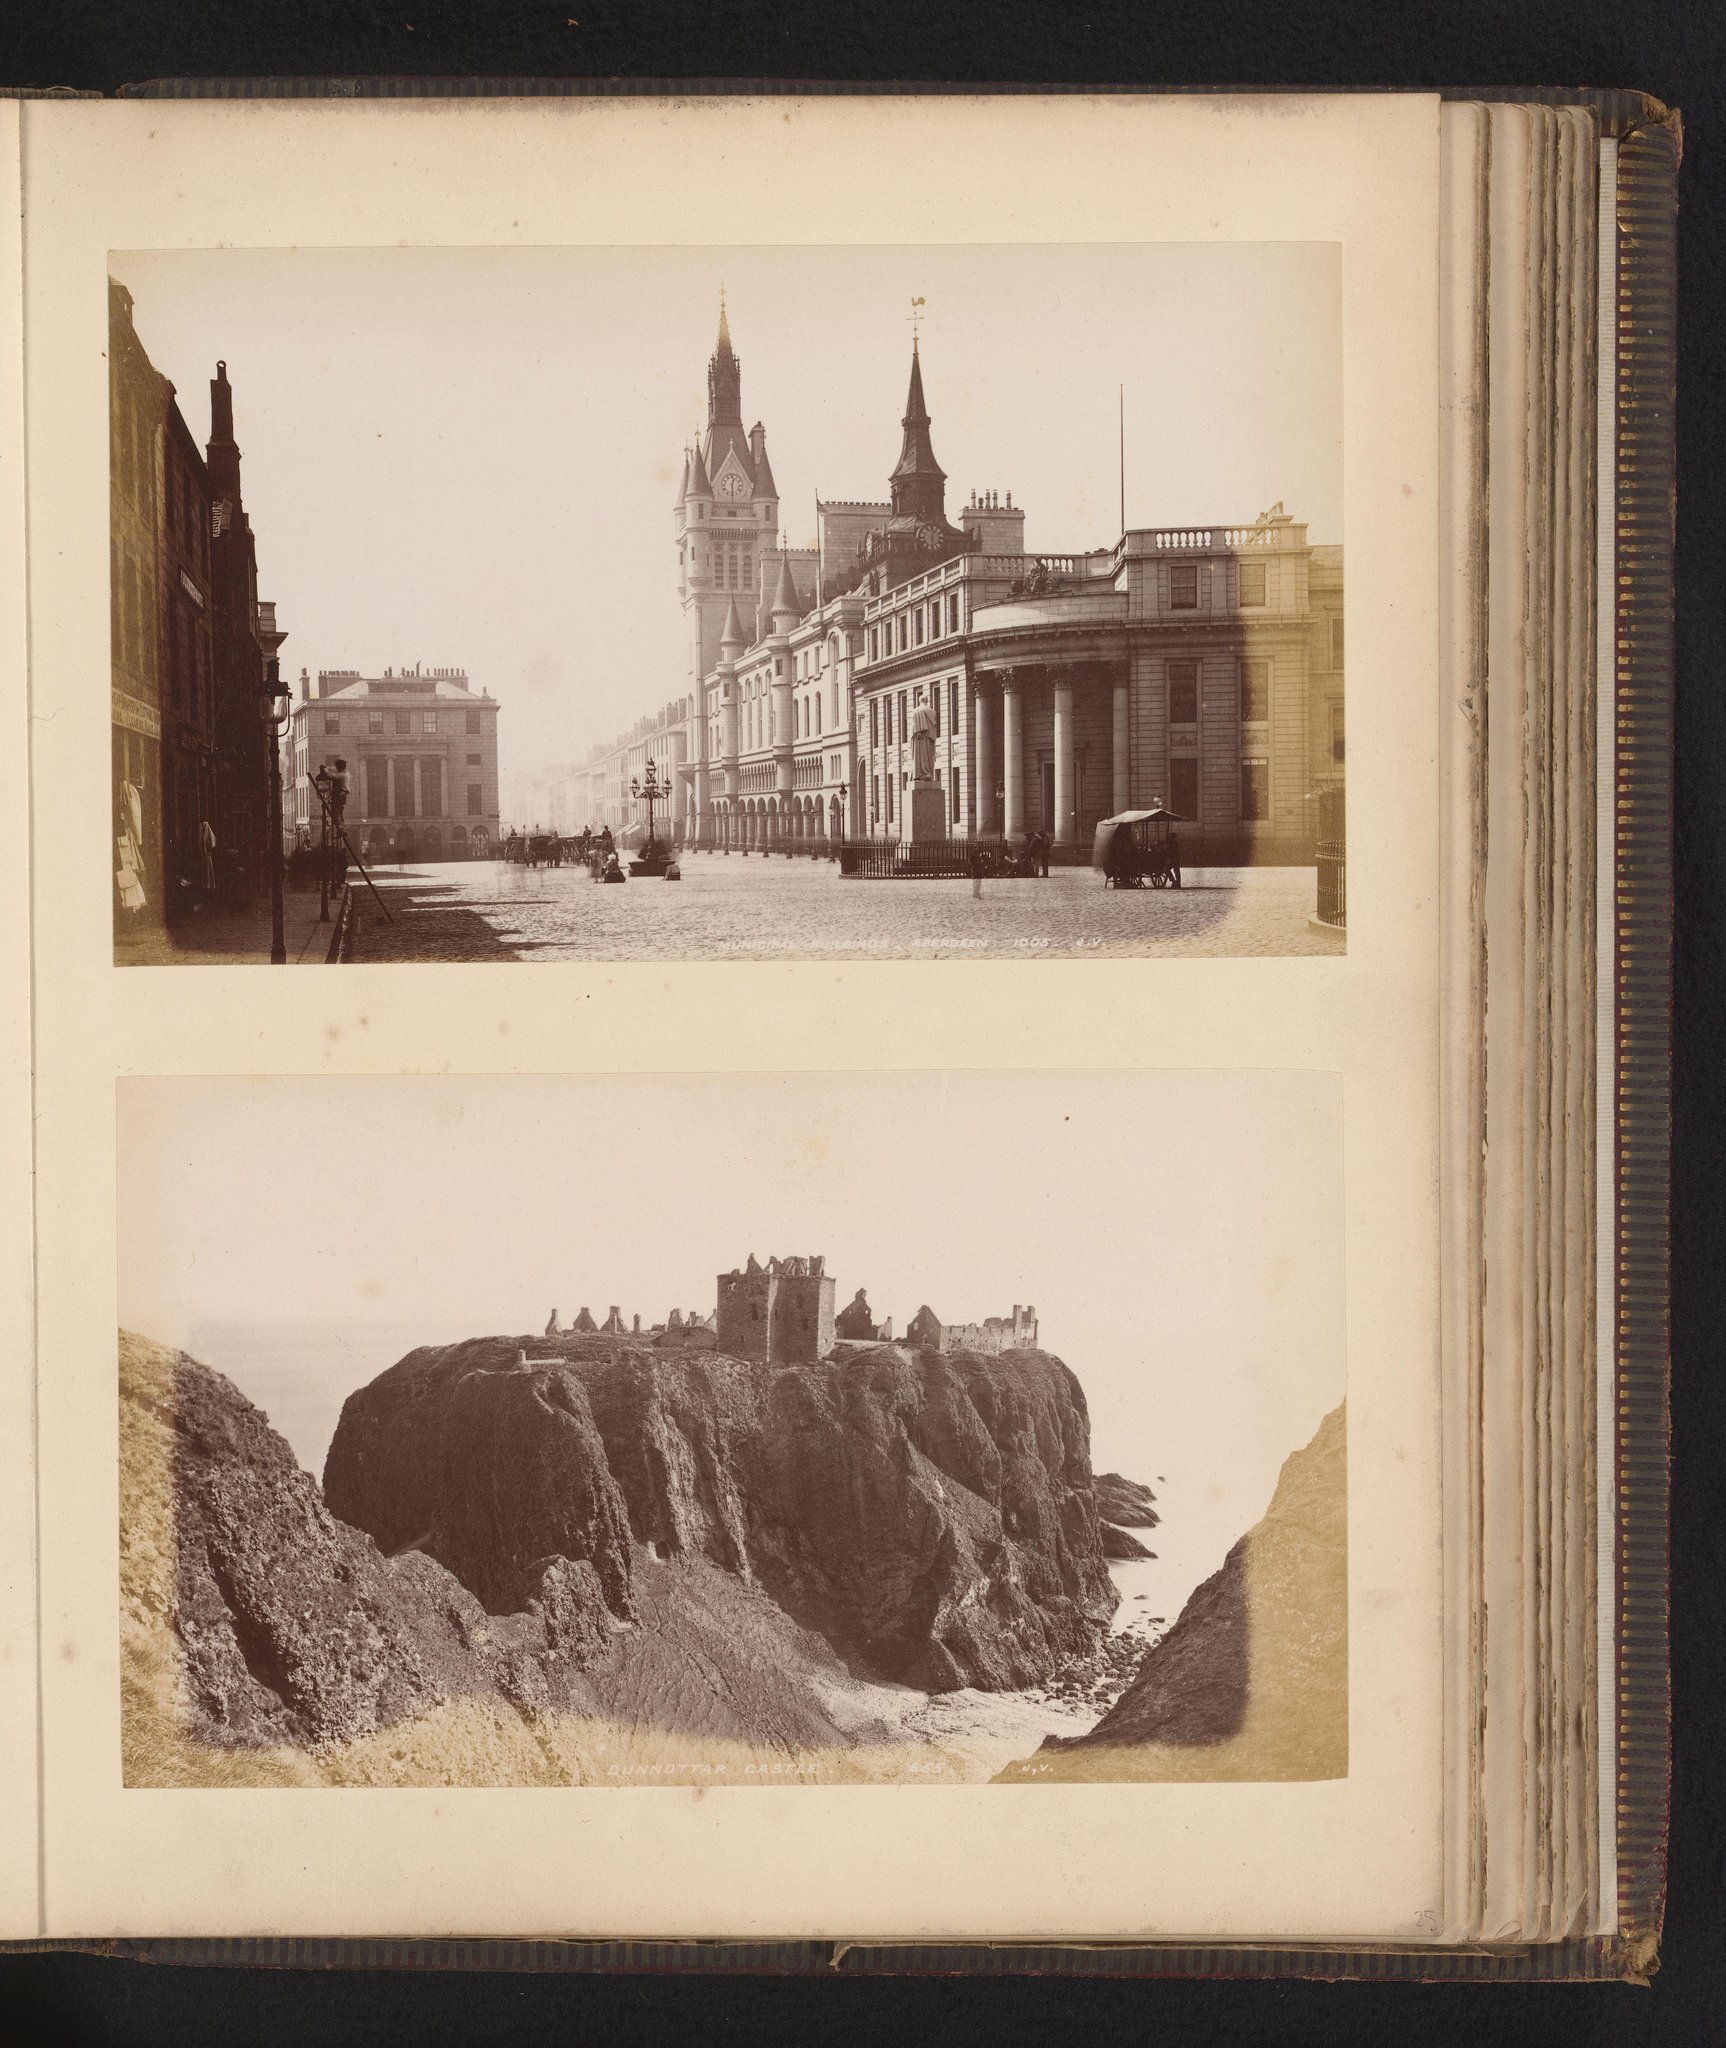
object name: photograph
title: Stadsgezicht te Aberdeen en Gezicht op Dunnottar Castle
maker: Anonymous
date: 1875-1885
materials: photographic support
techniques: albumen print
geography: aberdeen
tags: city-view, and landscape with man-made constructions, castle, street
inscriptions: number: ‘655, J.V.’, number: ‘1005, J.V.’